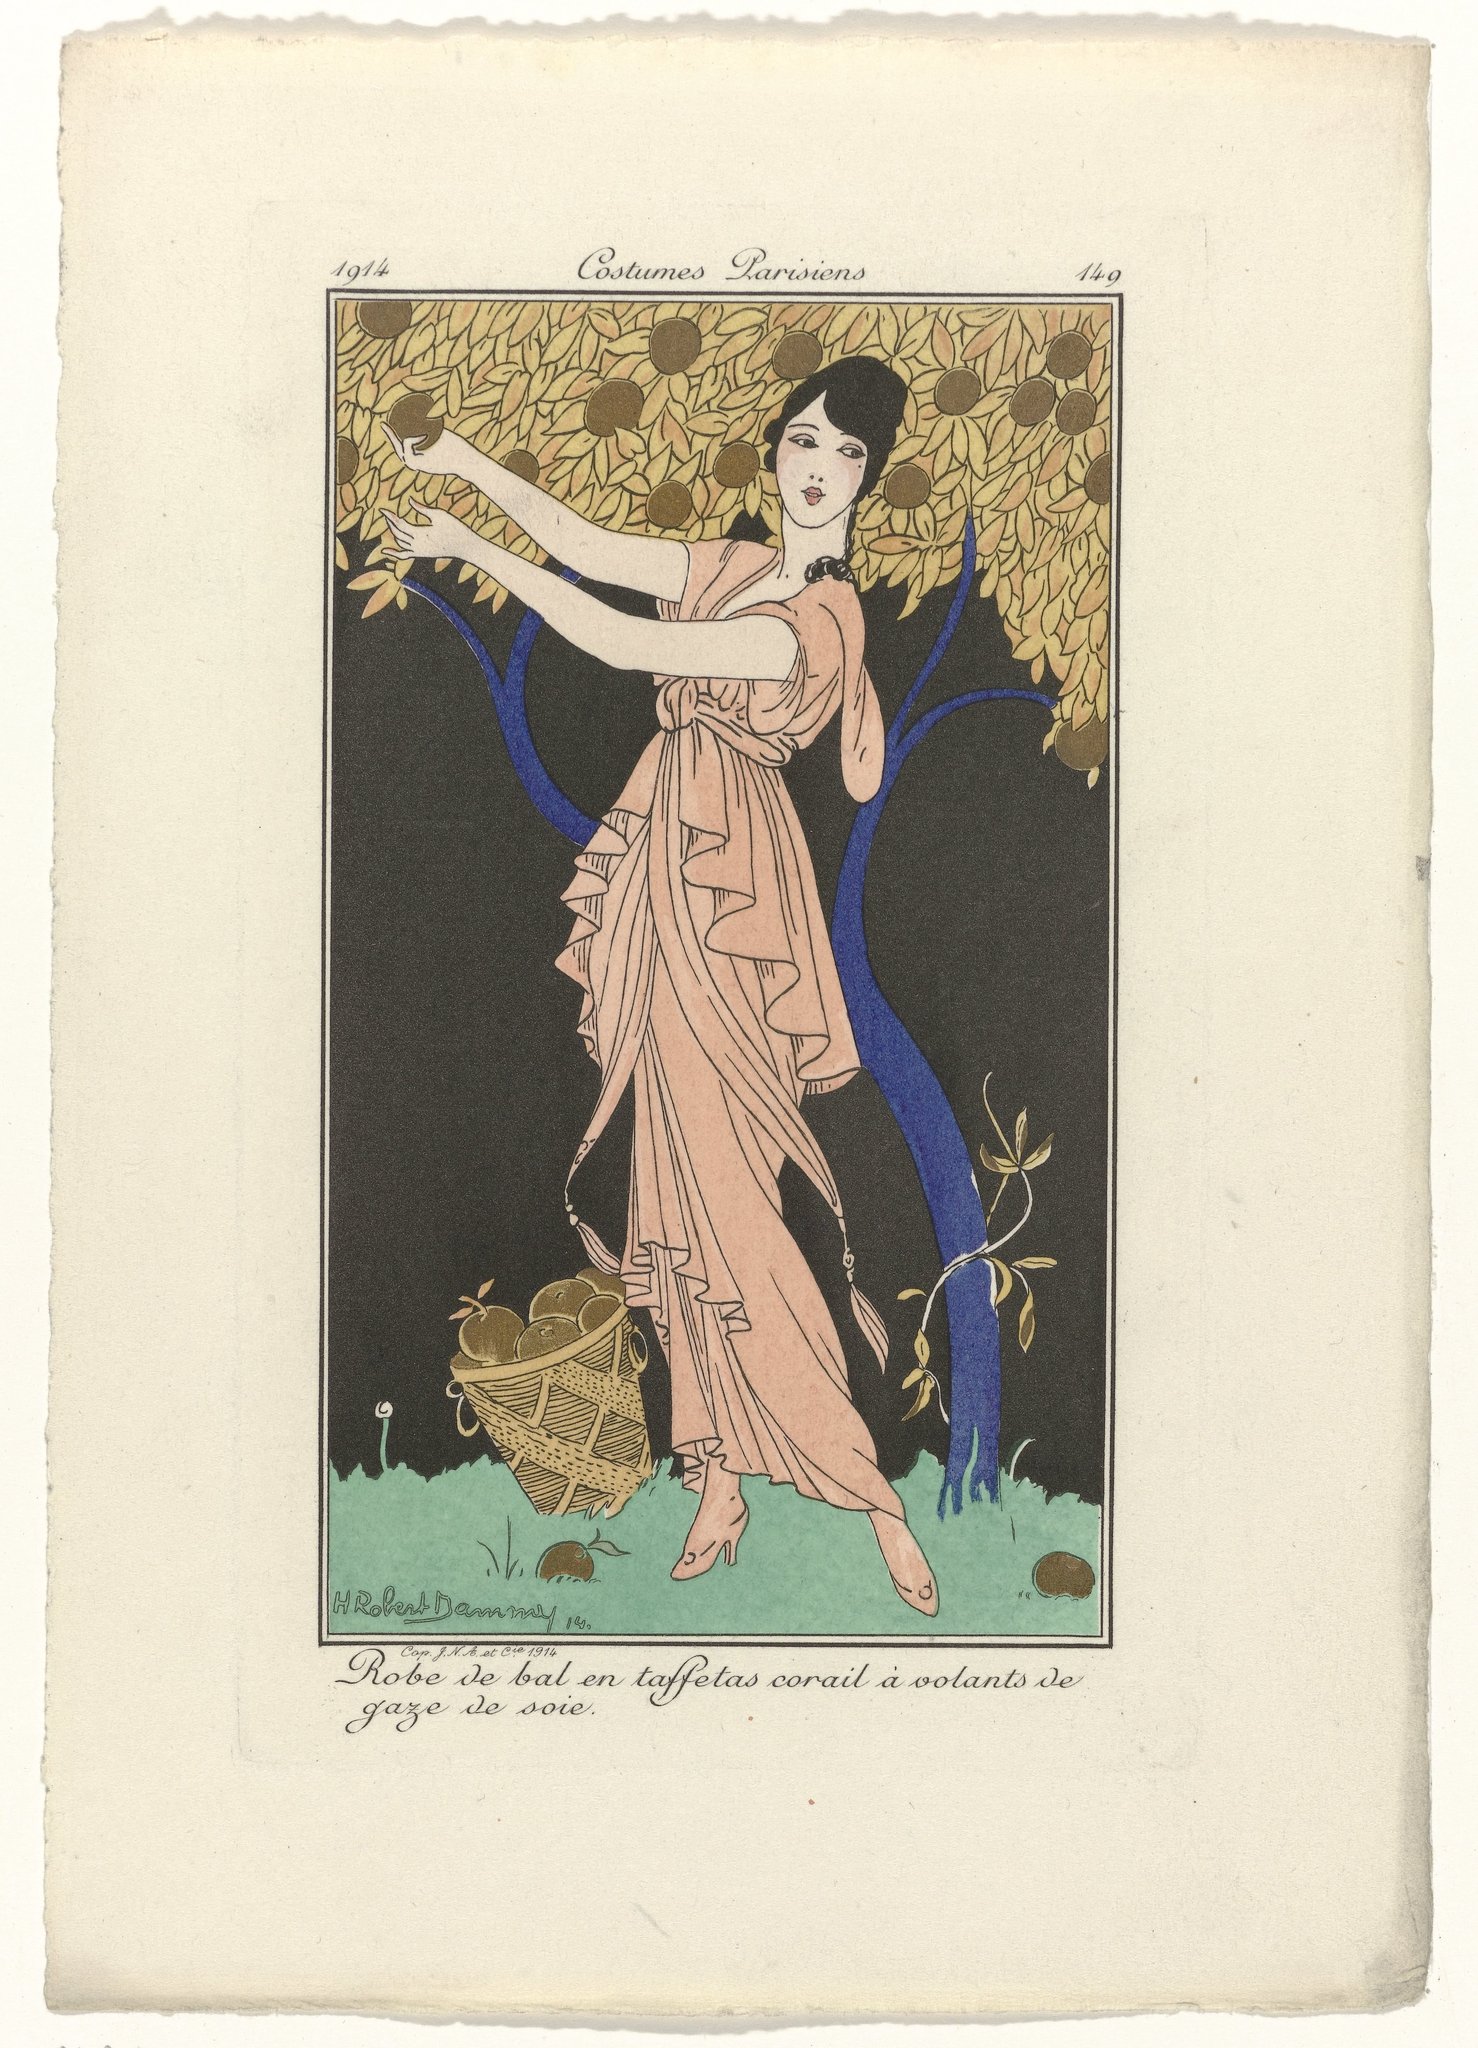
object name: fashion print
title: Journal des Dames et des Modes, Costumes Parisiens, 1914, No. 149: Robe de bal (...)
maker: Anonymous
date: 1914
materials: paper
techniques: engraving, hand coloring, pochoir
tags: fruits: apple, dress, gown: ball gown (+ women's clothes), fashion plates, picking fruit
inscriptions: inscription: ‘Cop. J. N. A. et Cie 1914’, caption: ‘Robe de bal en taffetas corail a volants de gaze de soie.’, title: ‘Costumes Parisiens’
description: Vrouw in een baljapon van koraalkleurige tafzijde met geplooide stroken stof van 'gaze de soie'. Zij staat voor een appelboom. Op de grond een mand met appels. Prent uit het modetijdschrift Journal des Dames et des Modes (1912-1914).